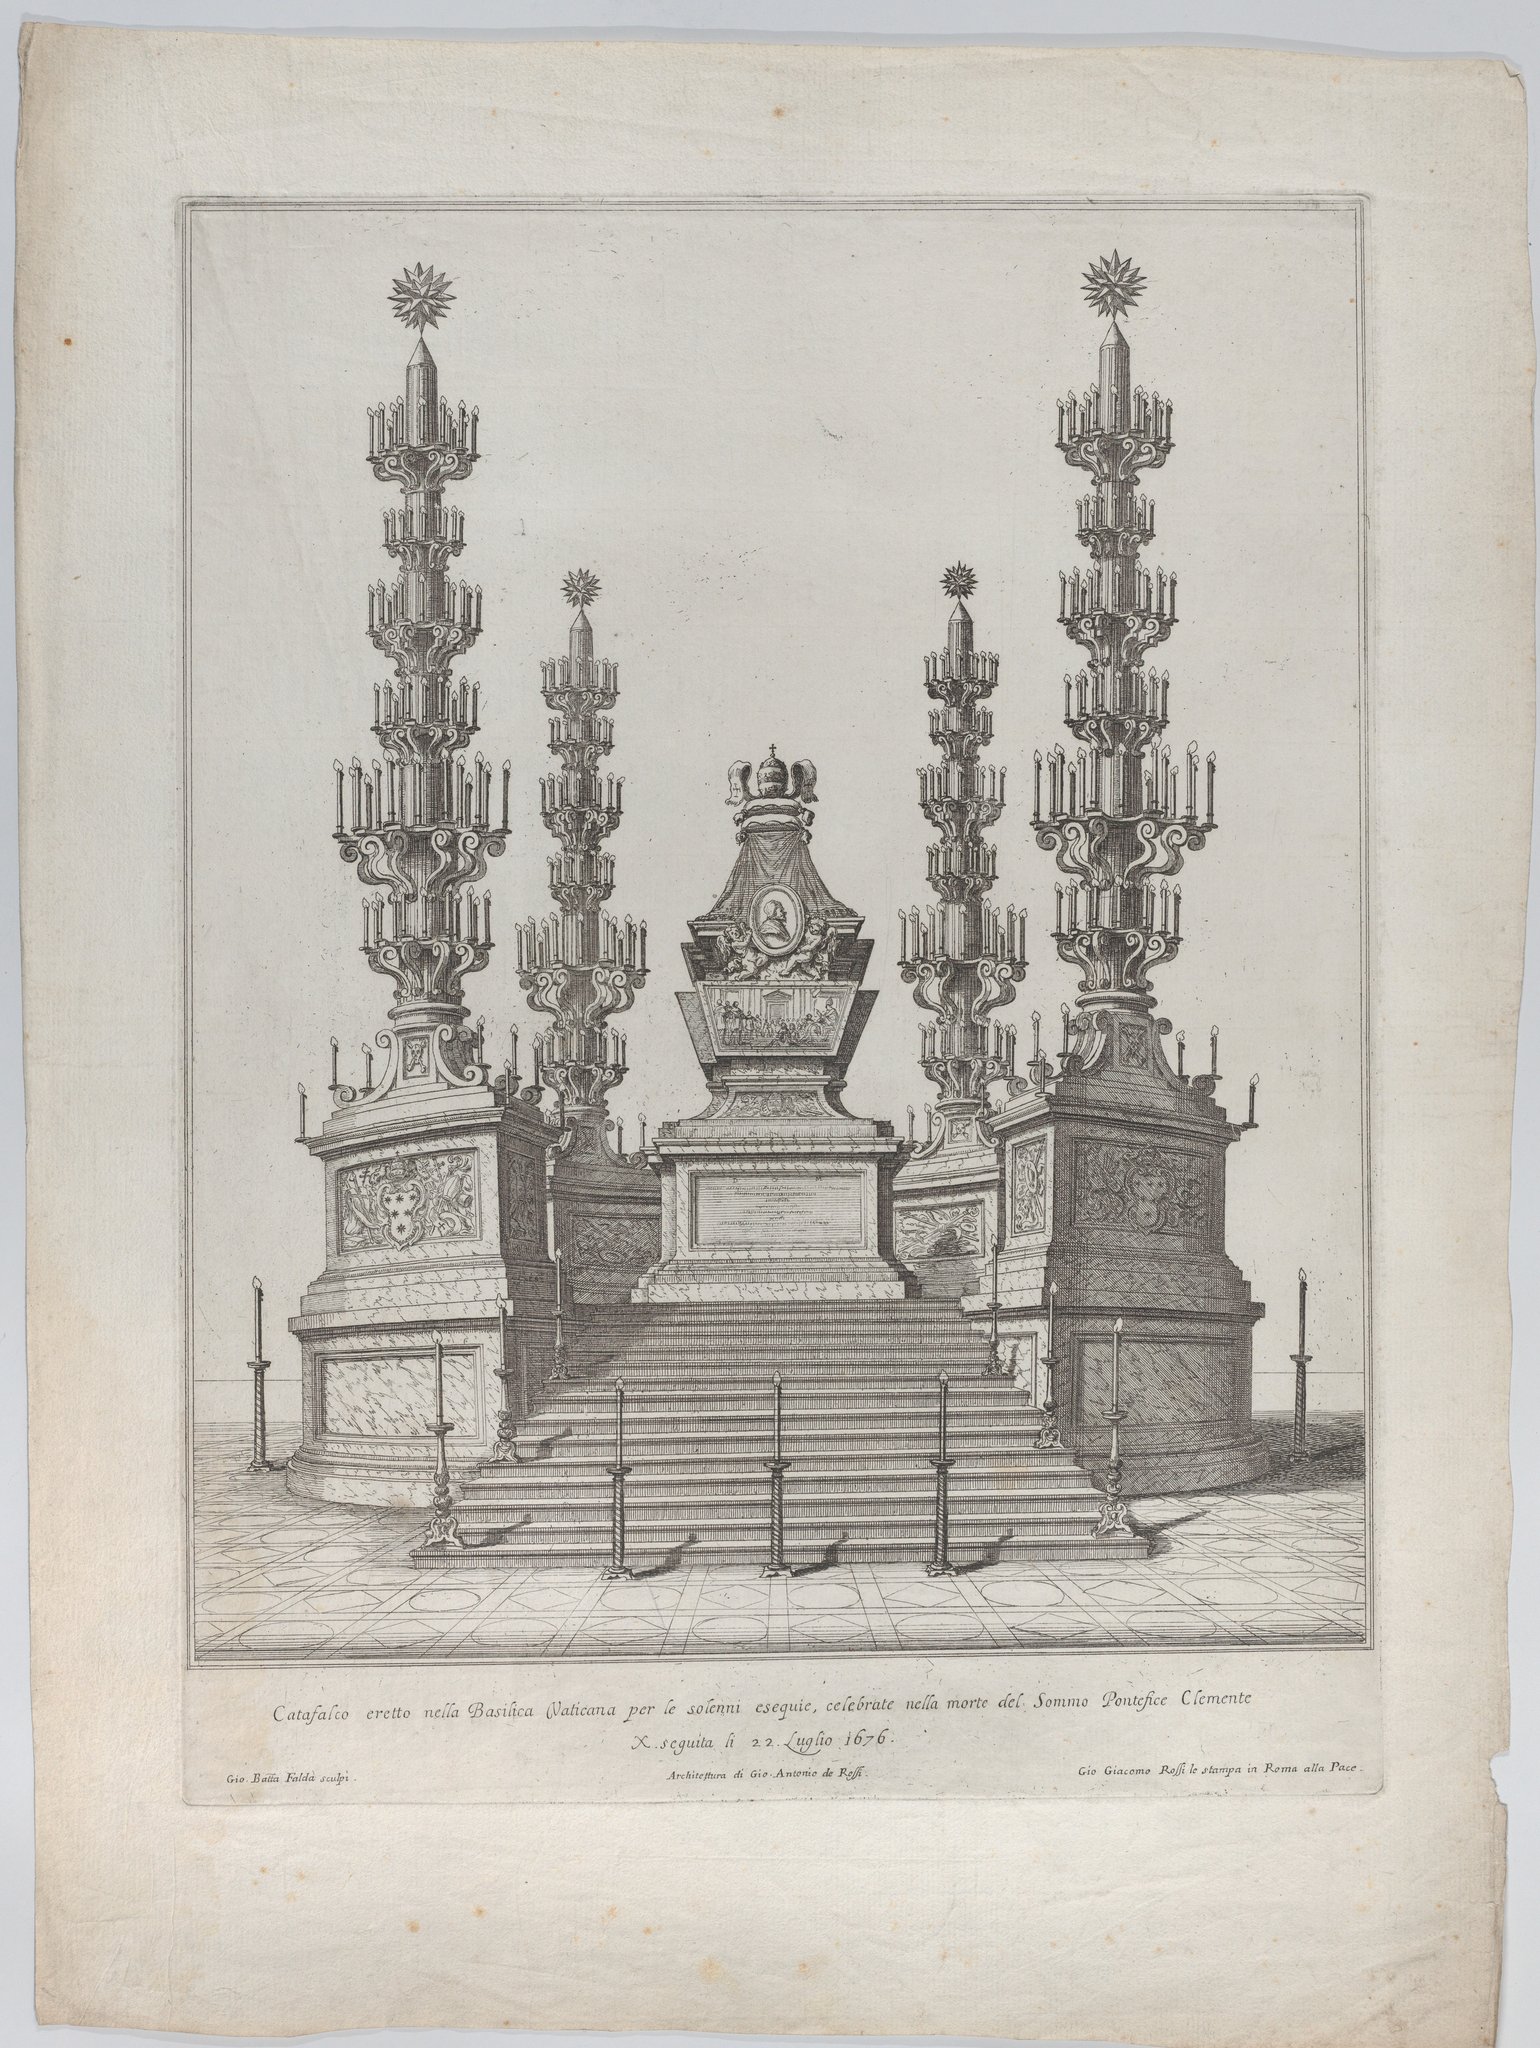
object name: print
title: Catafalque for Pope Clement X: a central structure raised on a 15 stepped platform, with columns surmounted by elaborate candelabra at each corner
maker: giovanni battista falda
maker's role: artist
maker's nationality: italian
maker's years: 1643-1678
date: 1676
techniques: engraving